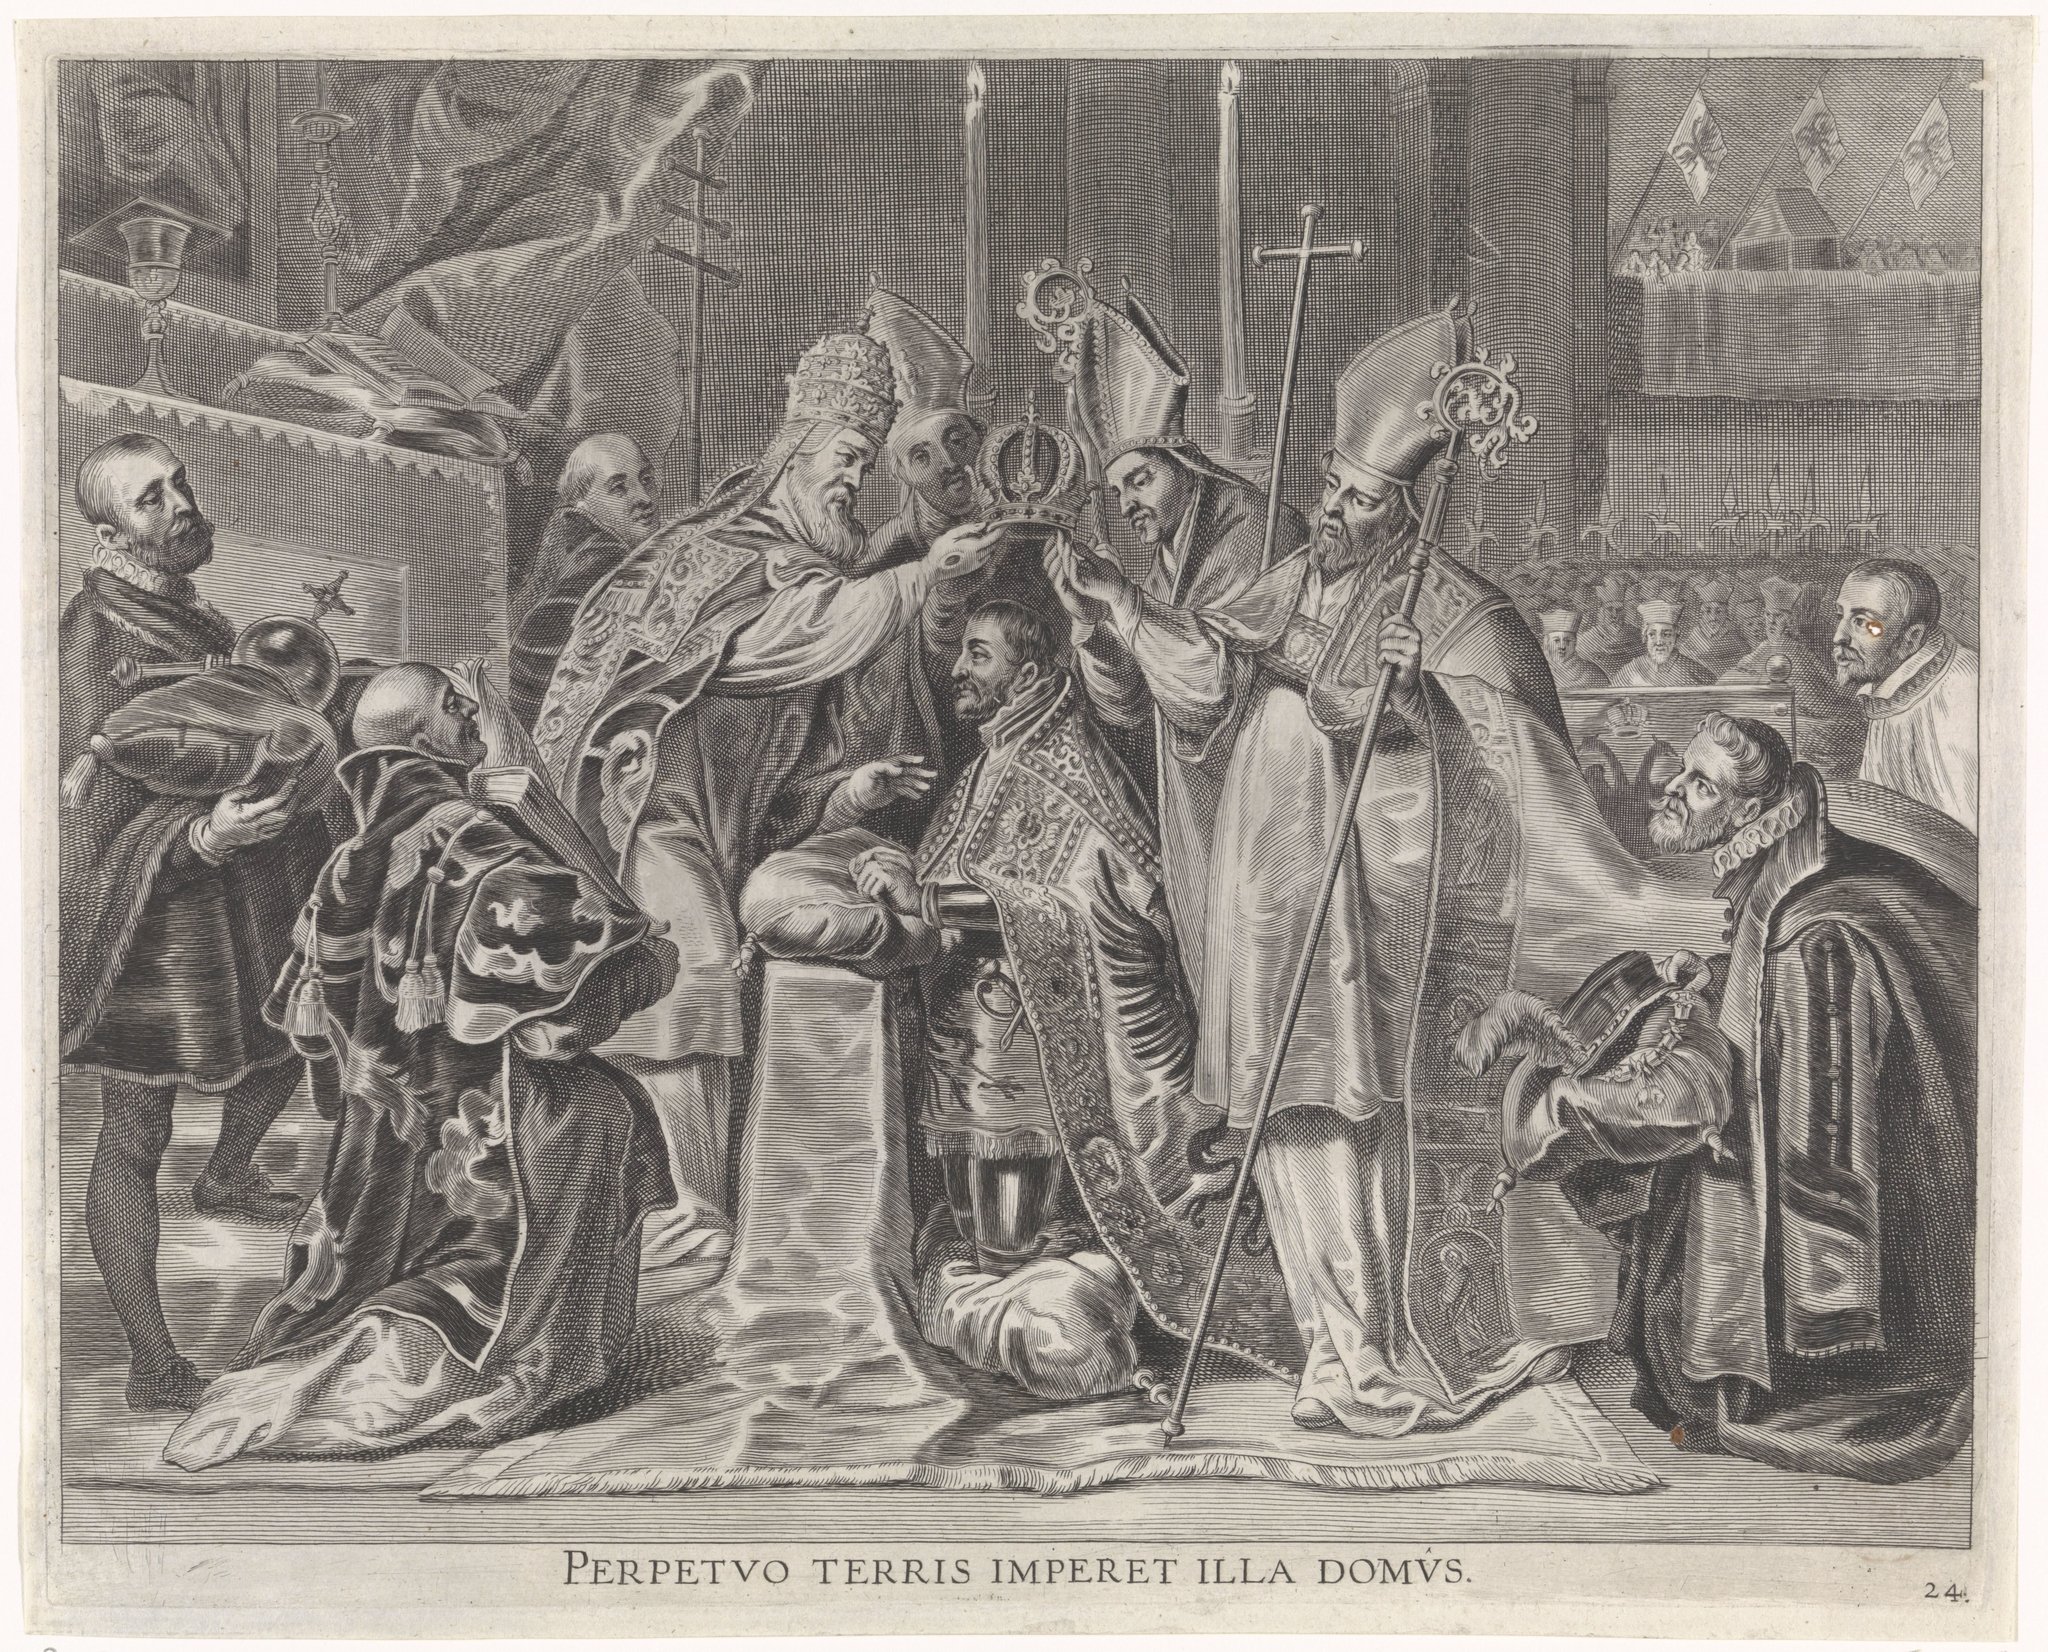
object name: print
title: Blijde intrede van de Kardinaal-Infant te Gent, 1635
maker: pieter de jode (ii)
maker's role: draughtsman, print maker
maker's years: 1606-1674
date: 1636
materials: paper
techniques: engraving, etching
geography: antwerp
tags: charles v (holy roman emperor and king of spain), landvoogd der zuidelijke nederlanden ferdinand van oostenrijk, during the coronation, ghent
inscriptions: collector's mark: Lugt 240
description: Karel V tot keizer gekroond door paus Clemens VII te Bologna, 24 februari 1530. In de marge een onderschrift in het Latijn. Vierentwintigste prent uit een serie van 42 die de uitgave van de beschrijving van de intocht van de Kardinaal Infant Ferdinand van Oostenrijk te Gent op 28 januari 1635 als de nieuwe landvoogd voor de Spaanse Nederlanden illustreren.